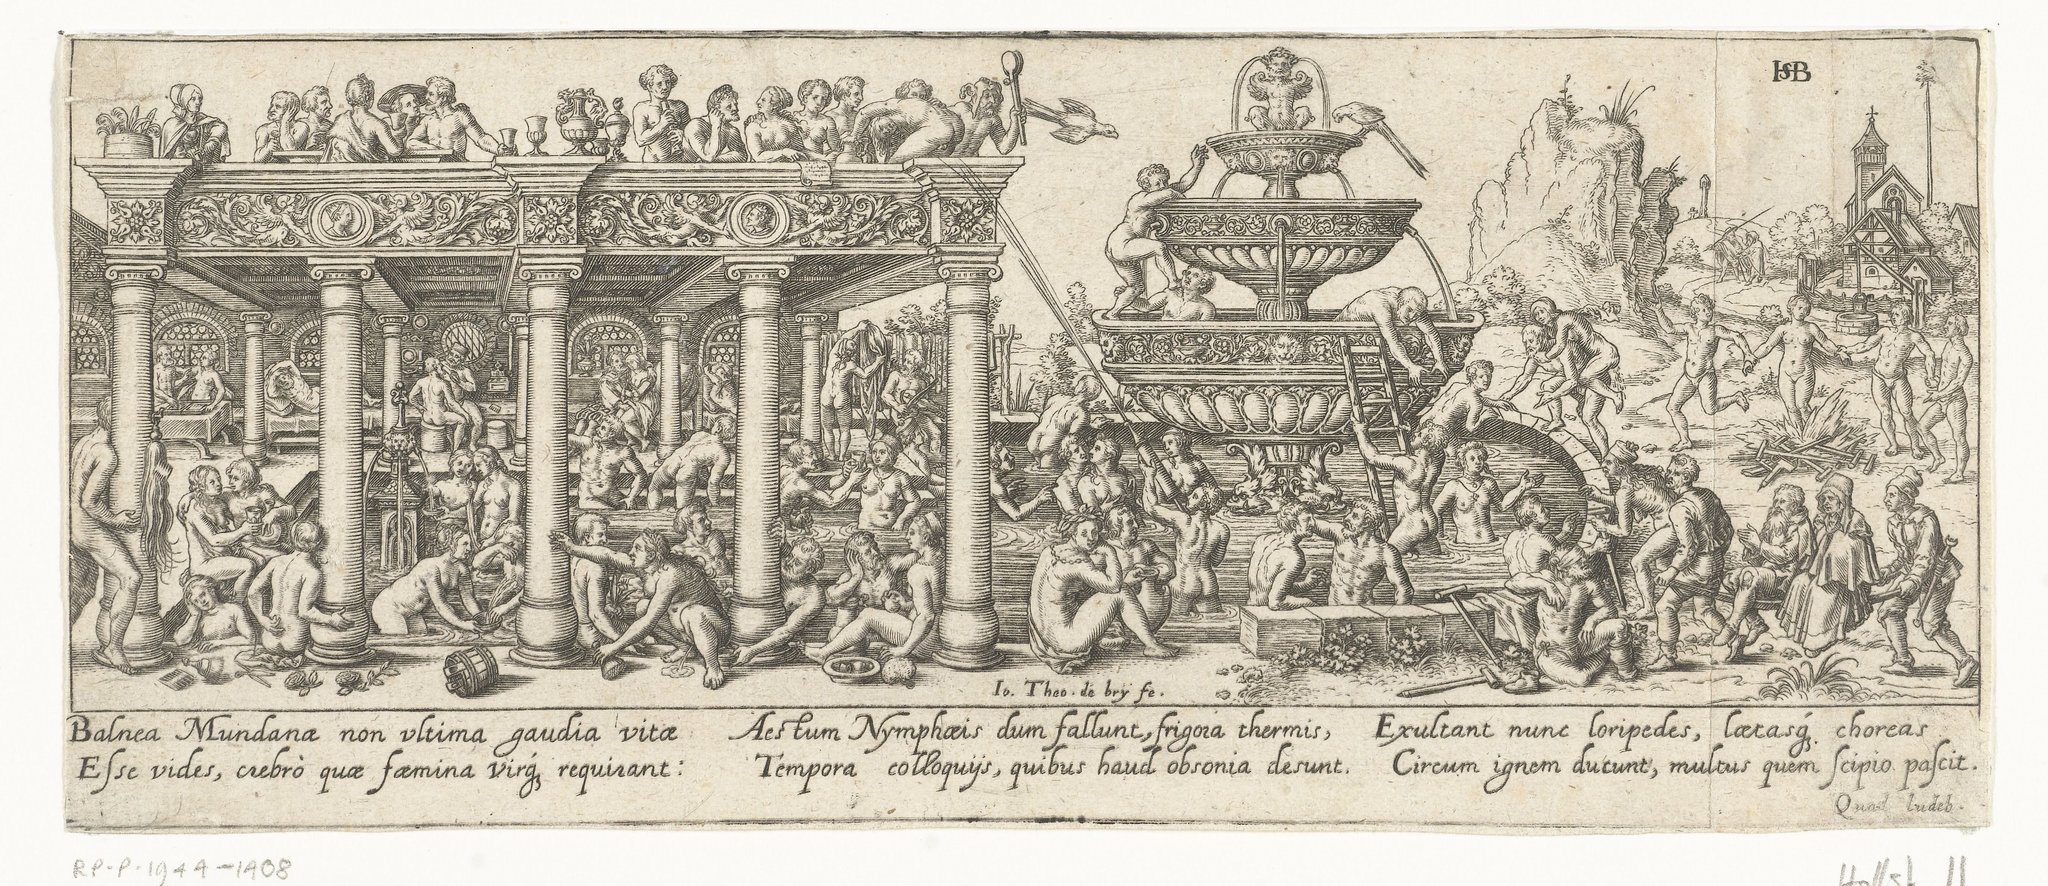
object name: print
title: Fontein der jeugd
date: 1588-1623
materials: paper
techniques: engraving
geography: germany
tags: court jester, court fool, fountain of youth, 'fontaine de jouvence', public baths - aa - in the open air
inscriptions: caption: ‘Balnea Mundanae non ultima gaudia vitae...Circum ignem ducunt, multus quem scipio pascit.’, collector's mark: Lugt 2228, collector's mark: Lugt 699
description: Een badhuis met badende mannen en vrouwen en, op het "dakterras", minnende en musicerende mensen. Rechts de fontein der jeugd, waarin oude en gebrekkigen worden gedompeld. Verjongd komen zij eruit te voorschijn. Rechtsachter staat een verjongde vrouw in een vuur waarin krukken en stokken verbranden. Drie naakte mannen eromheen. Een nar, op het terras, bespot het geheel.